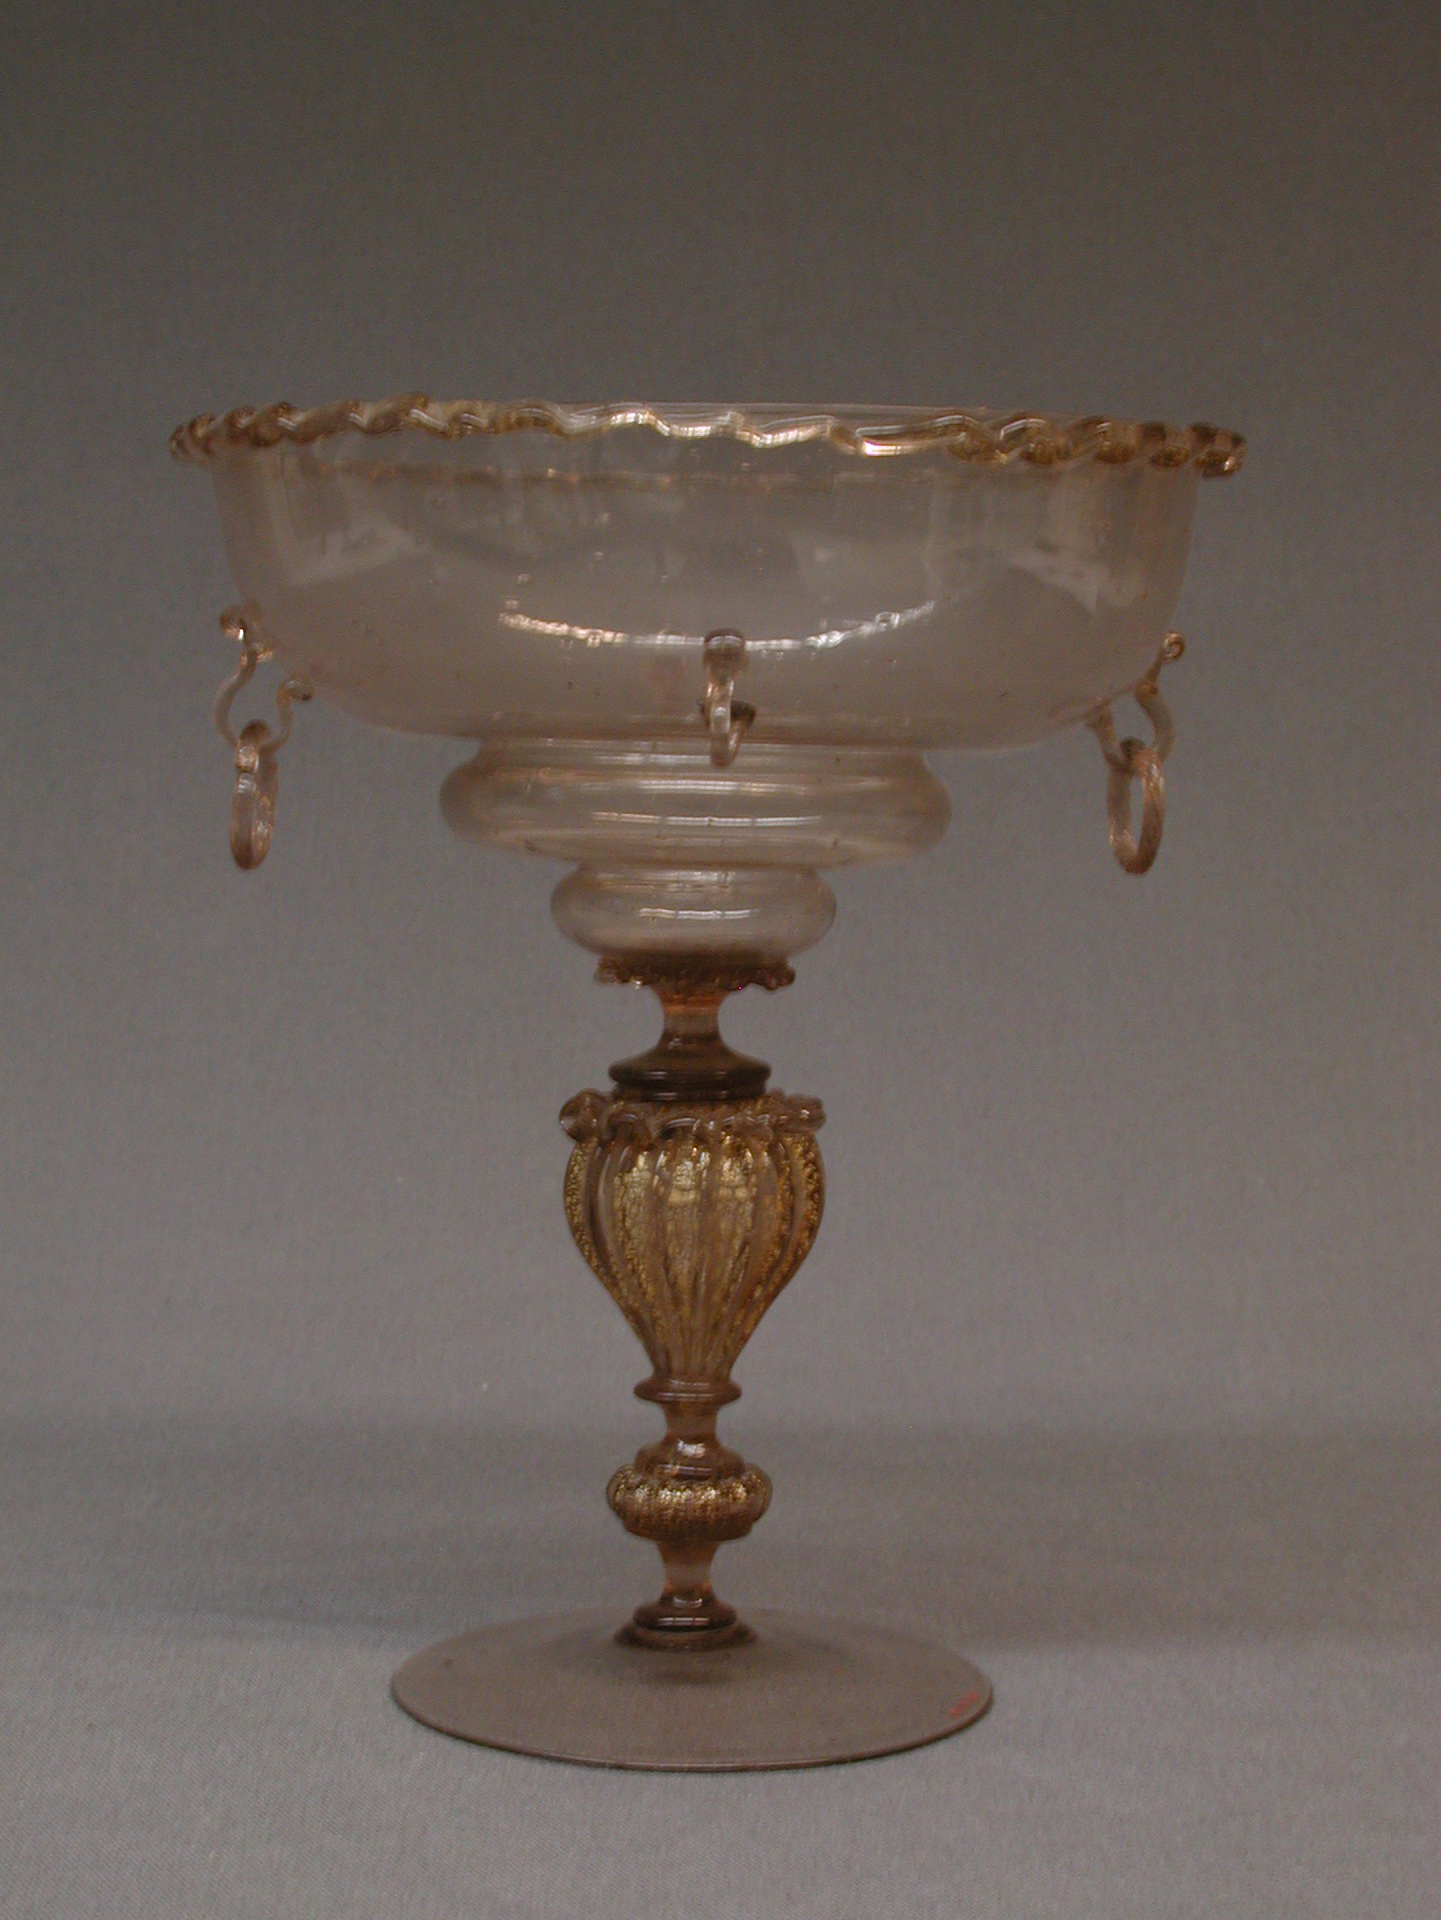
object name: cup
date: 1801-1900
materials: glass